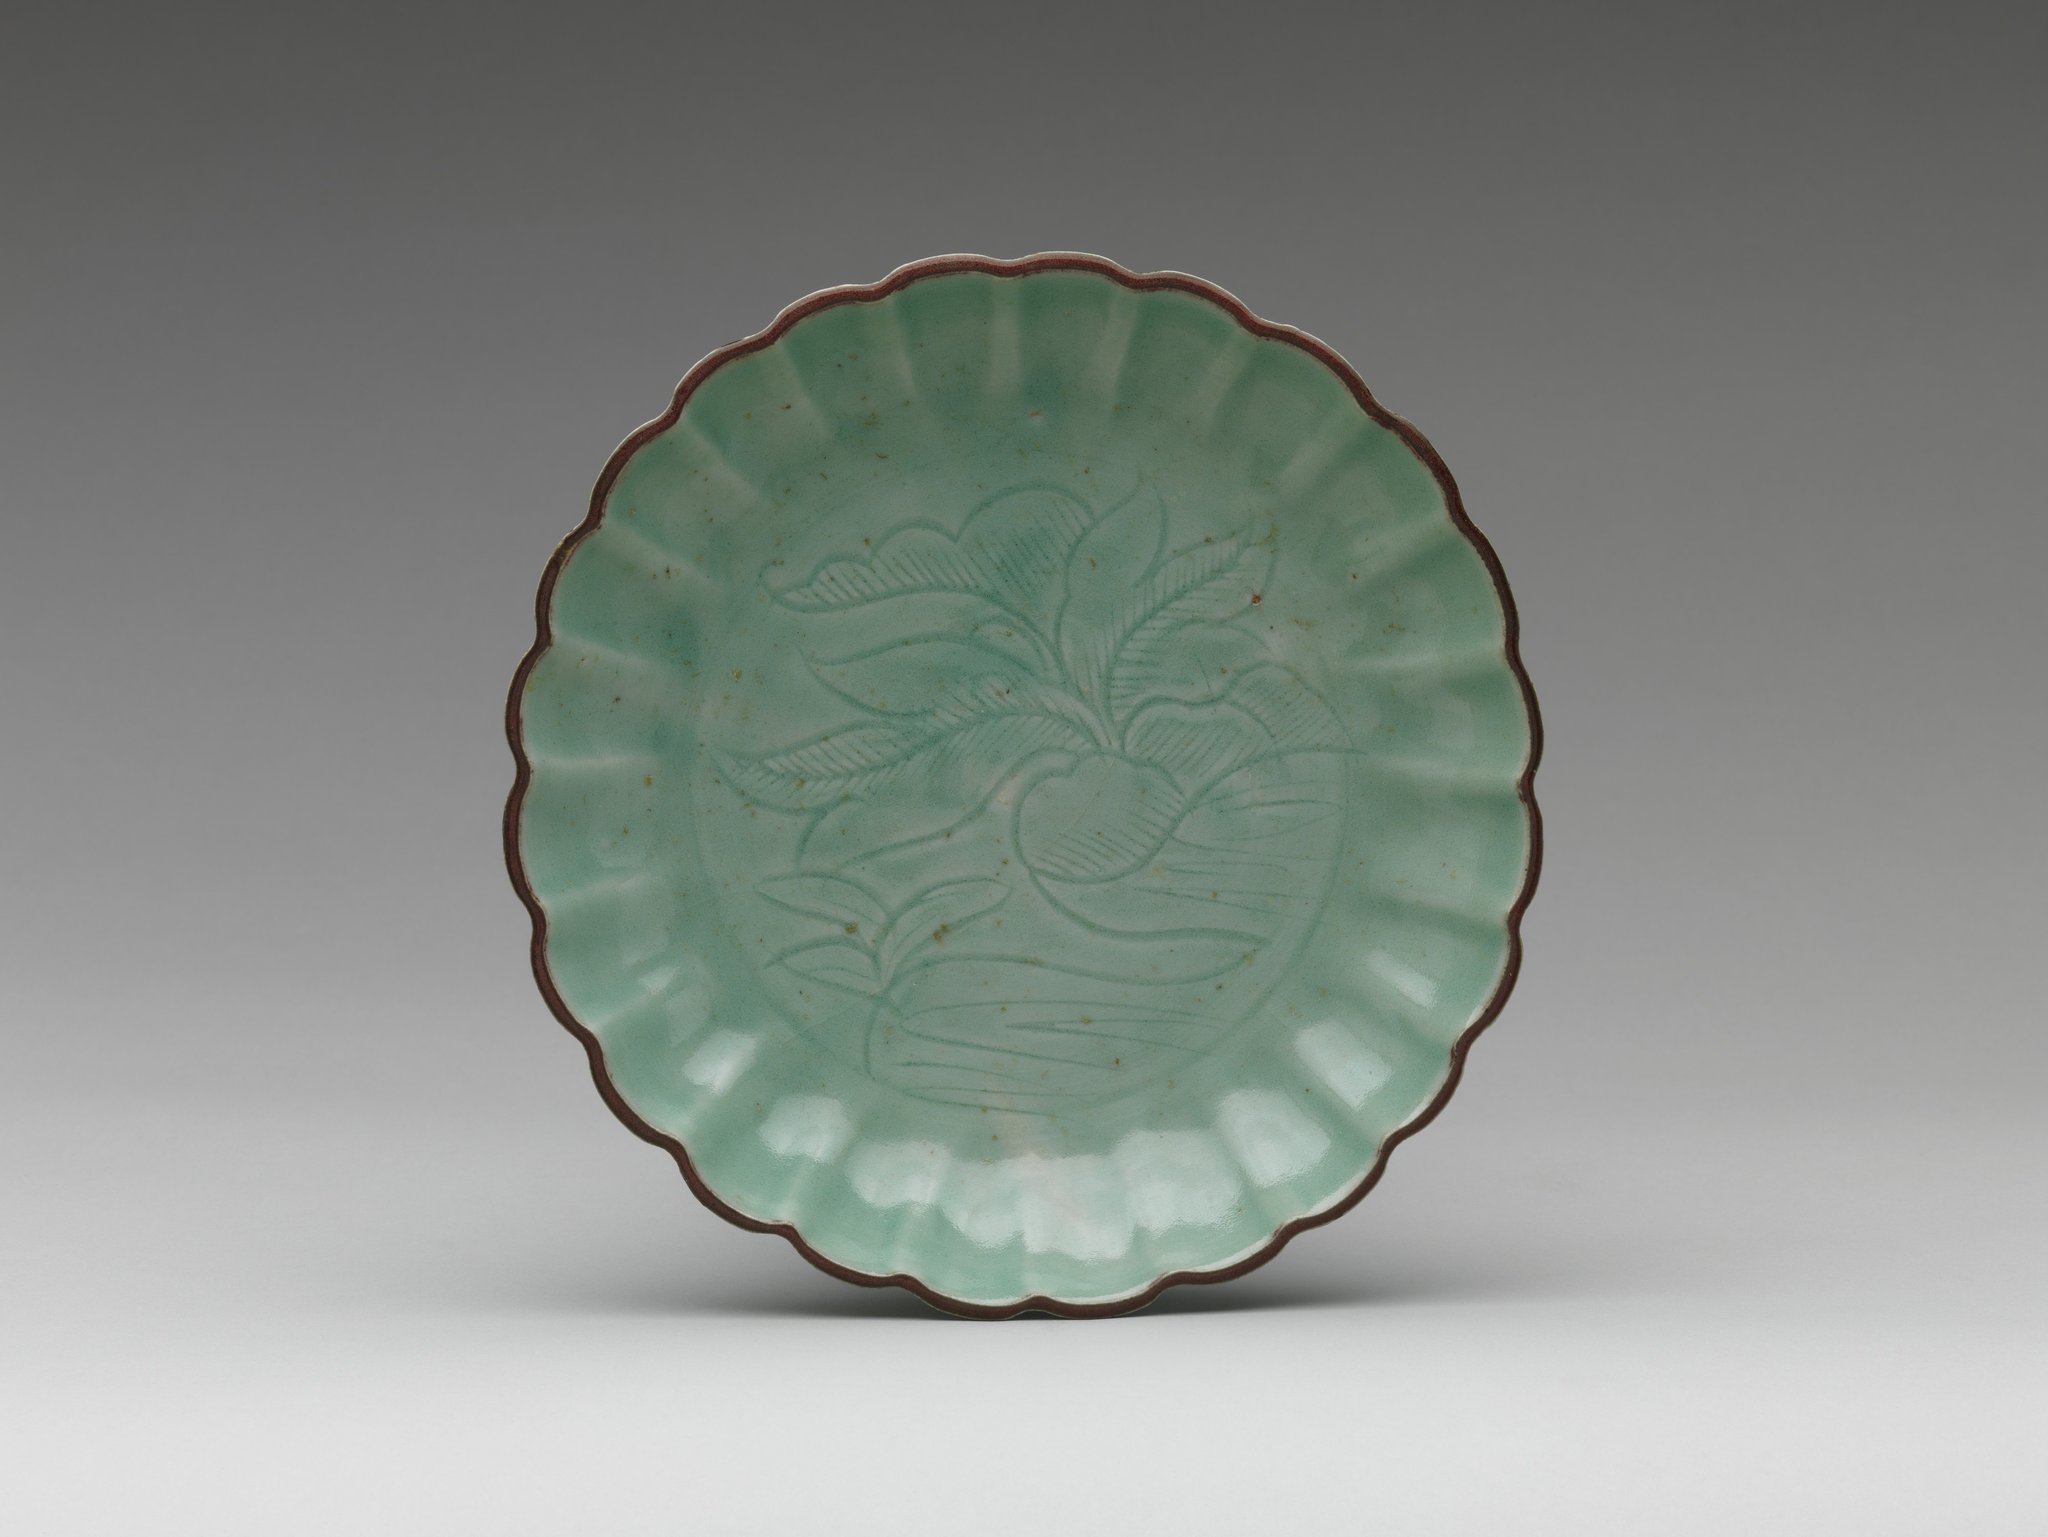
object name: dish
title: Dish with Vegetal Design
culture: japanese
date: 1634-1666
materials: ceramic glaze, glaze, porcelain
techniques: incising